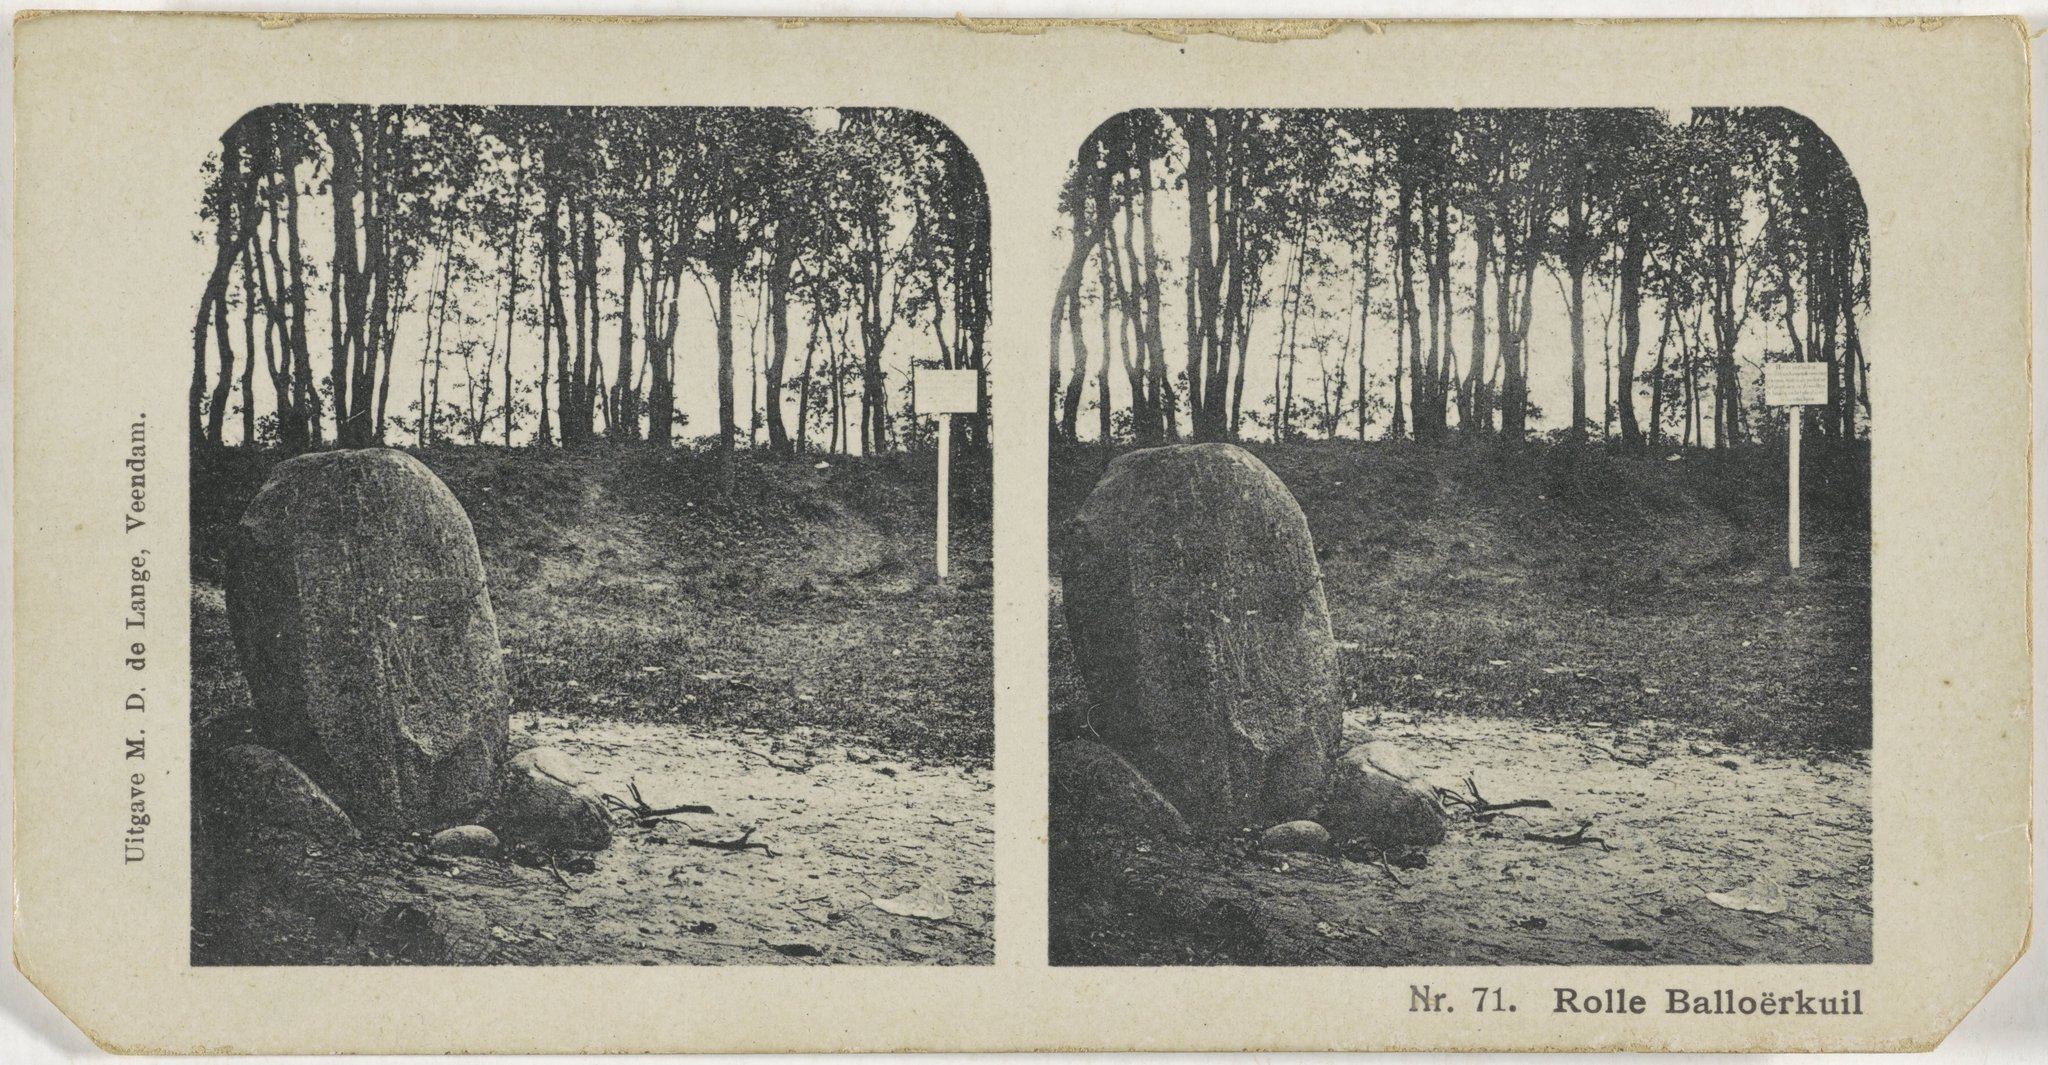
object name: photomechanical print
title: Rolle Balloërkuil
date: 1900-1911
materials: paper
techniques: photograph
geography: veendam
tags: forest, wood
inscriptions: number: ‘Nr. 71.’